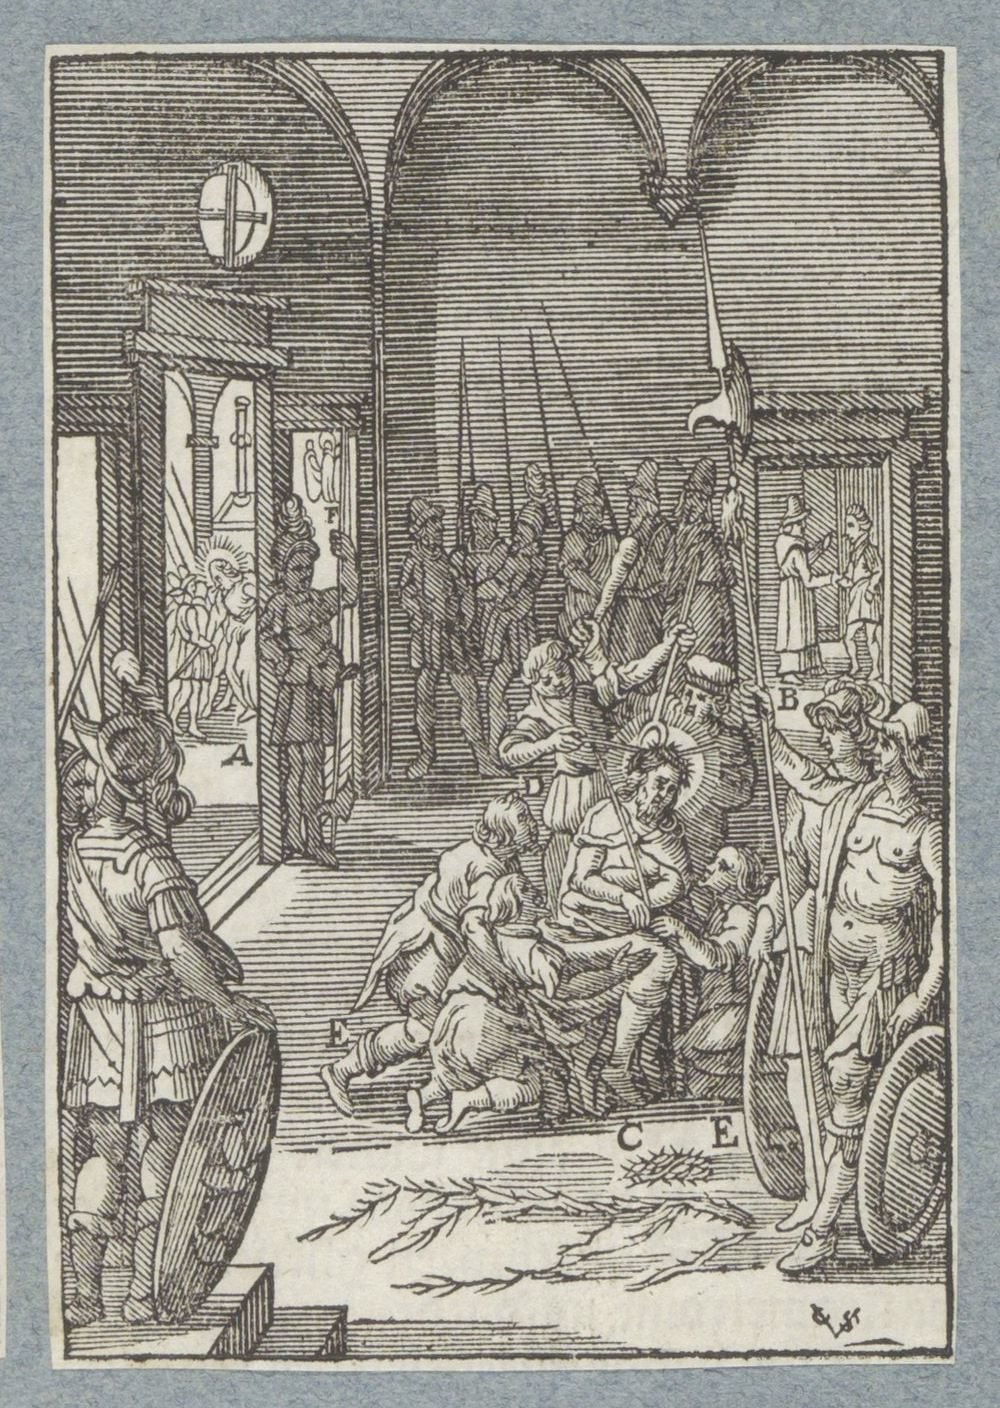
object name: album leaf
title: Geseling van Christus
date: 1629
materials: paper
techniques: letterpress printing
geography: amsterdam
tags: flagellation by soldiers, christ usually tied to a column (matthew 27:26; mark 15:15; john 19:1)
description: De prent is afkomstig uit een van de uitgaven van P.J. Paets uit Amsterdam. De prent wordt voor het eerst gebruikt in: Der Zielen Lust-hof. Leuven, I.Jacbosz voor P.J. Paets [= Amsterdam, P.J. Paets], 1629. De voorstelling is gekopieerd naar een prent van Hieronymus Wierix voor: Nadal, Jerónimo. Evangelicae Historiae Imagines. Antwerpen, M. Nutius, 1593.